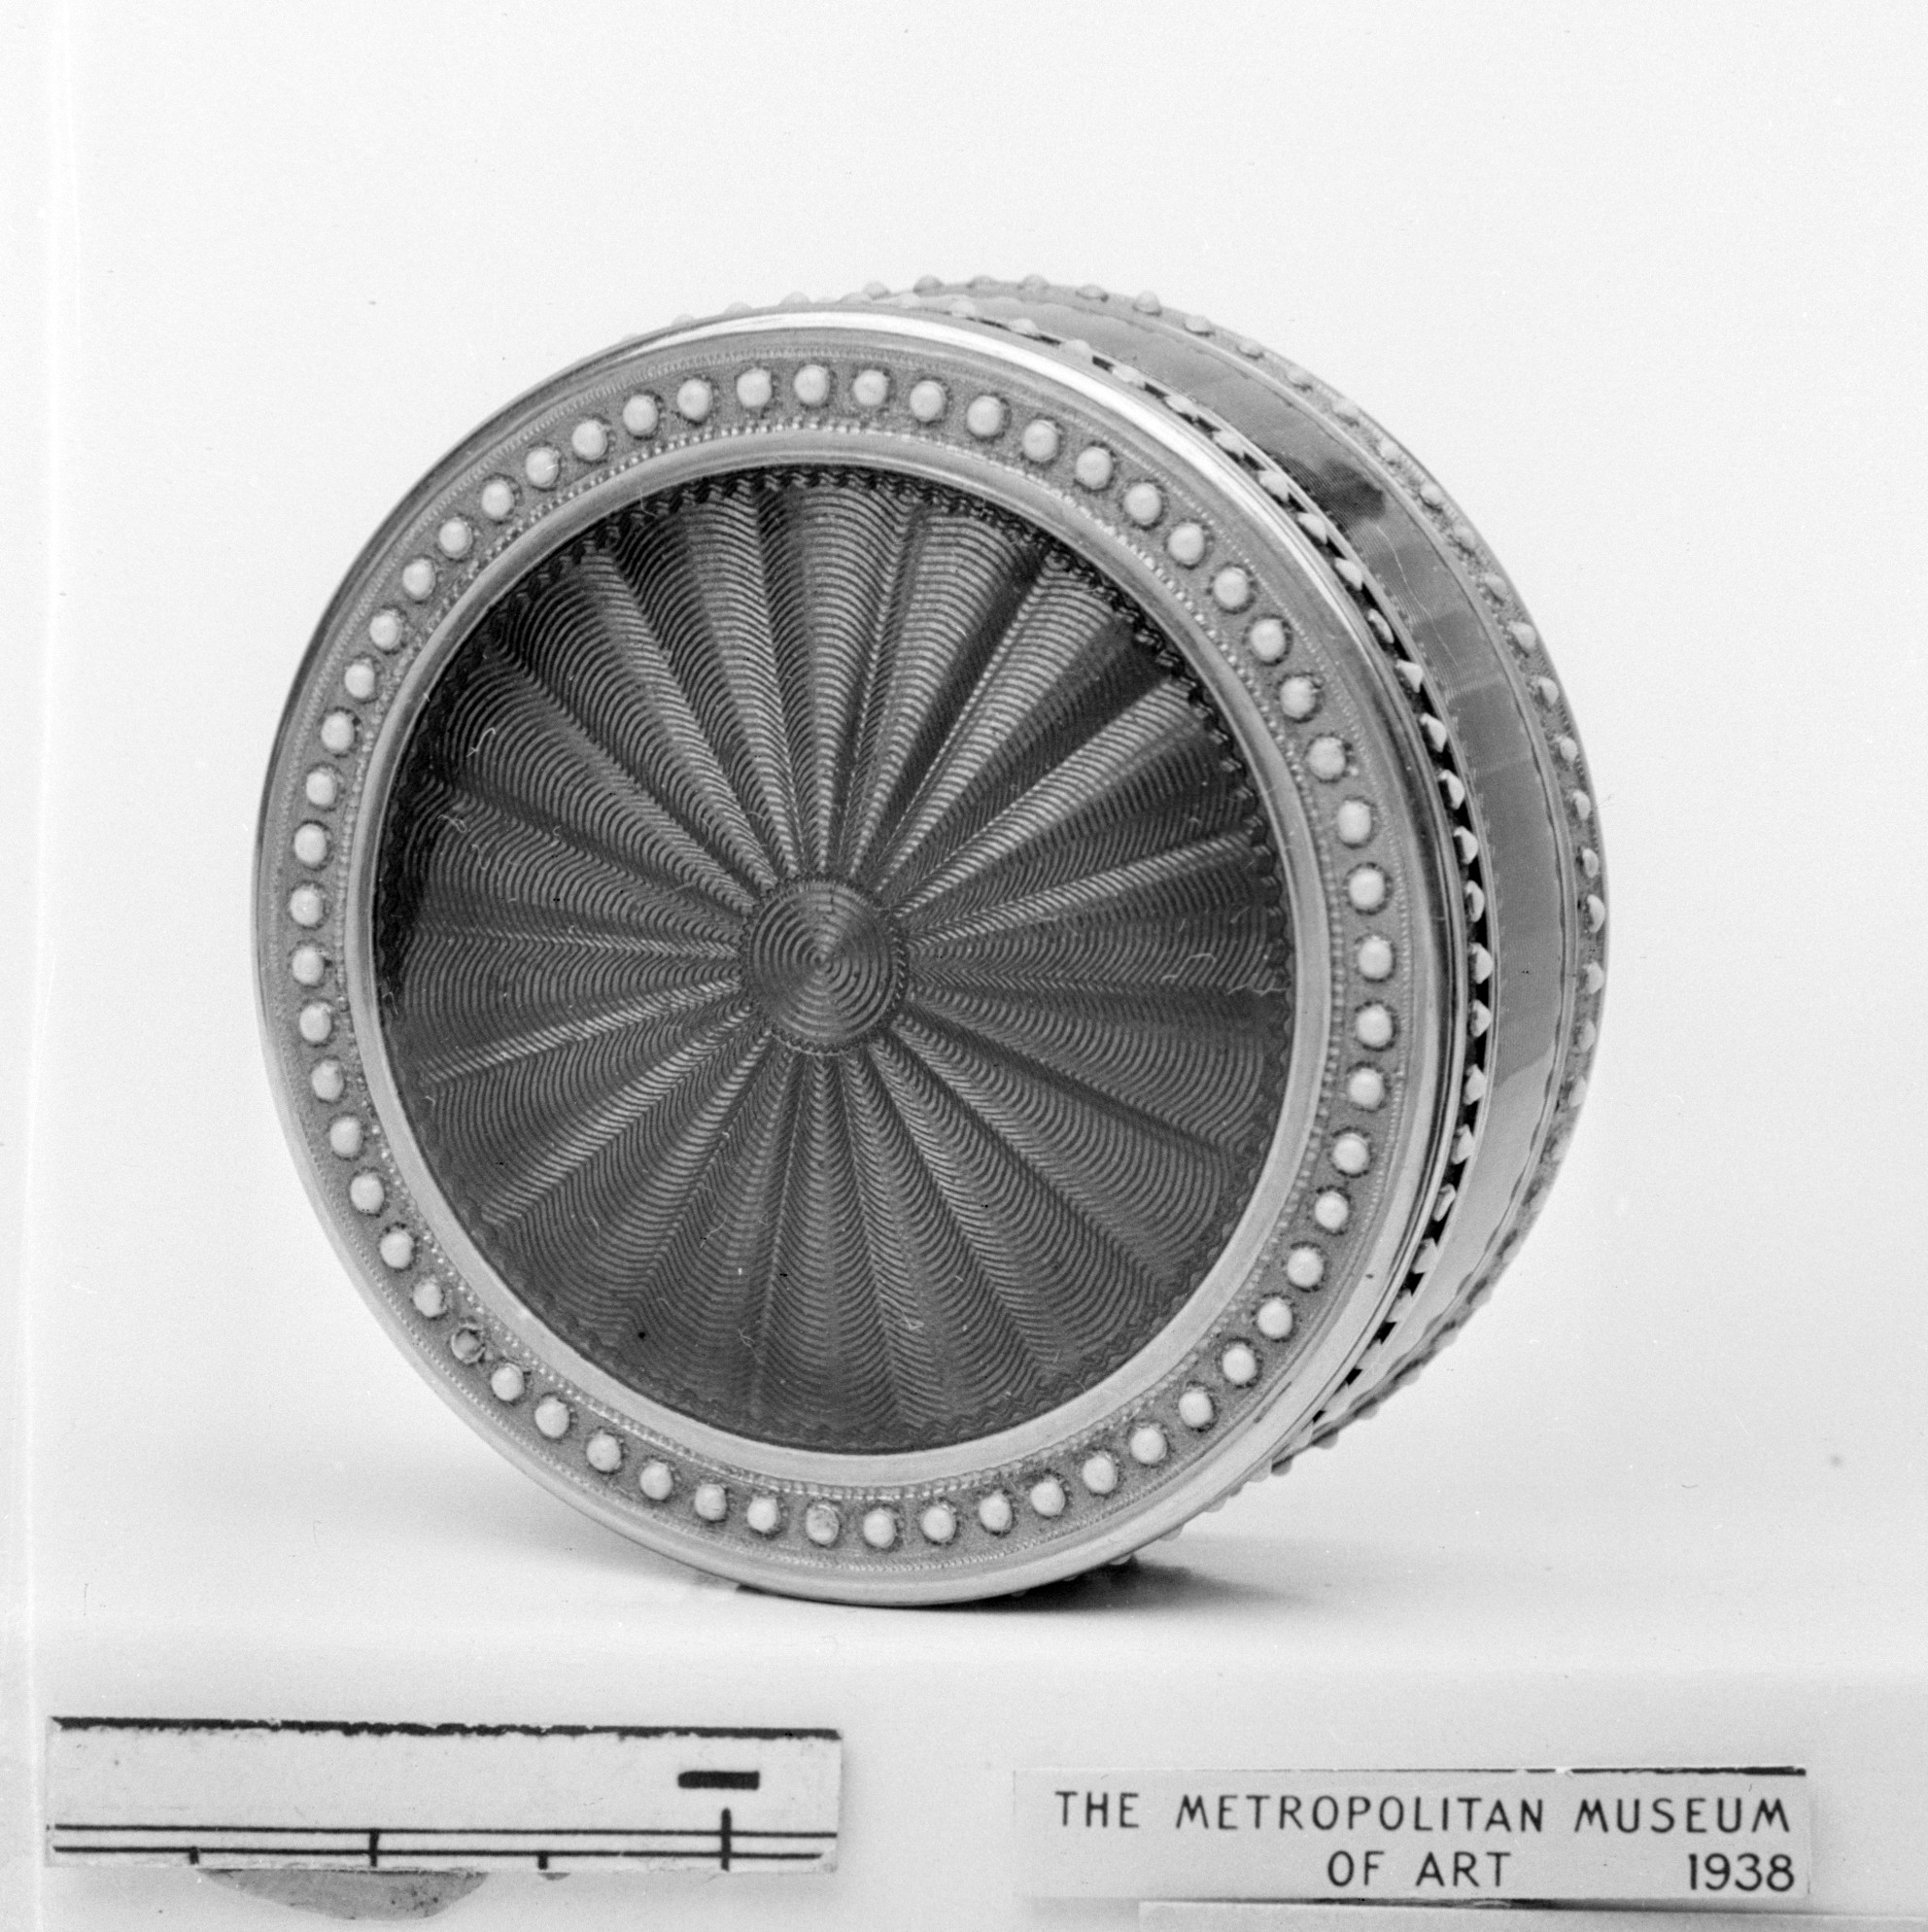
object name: box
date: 1801-1900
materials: enamel, gold